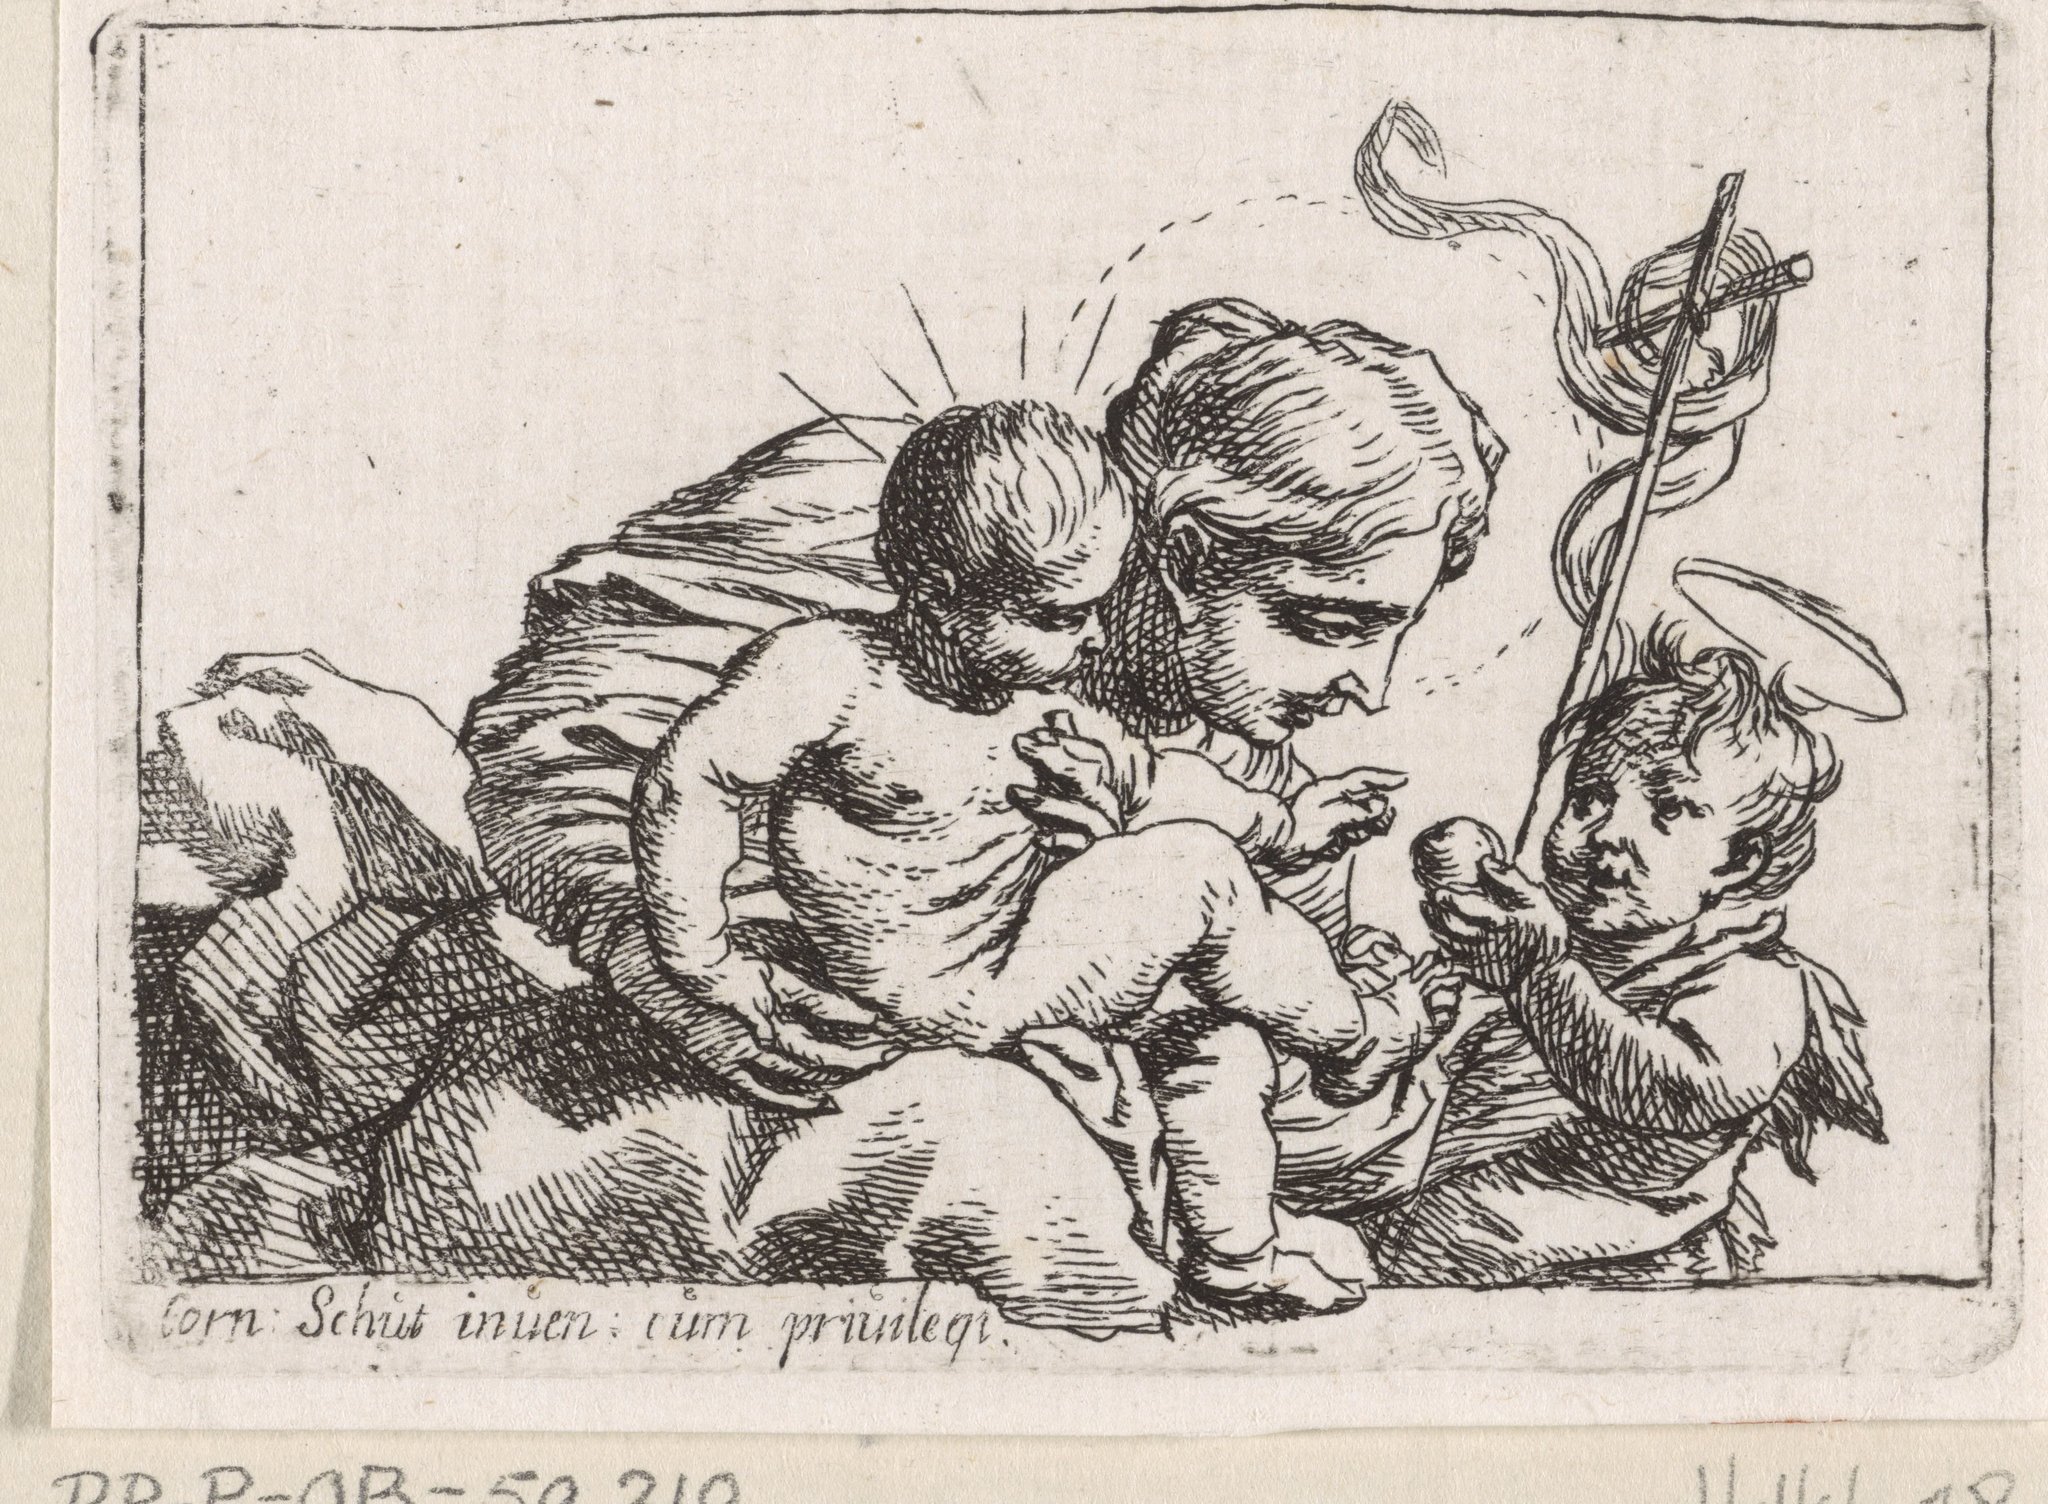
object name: print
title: Madonna met kind en Johannes de doper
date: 1618-1655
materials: paper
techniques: etching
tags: mary and the christ-child with john the baptist (as child)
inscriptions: collector's mark: Lugt 240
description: Het Christuskind zit bij Maria op schoot. Maria kijkt naar de appel die de jonge Johannes de Doper aan het Christuskind aanbiedt. In zijn andere hand houdt Johannes een overwinningsbanier.